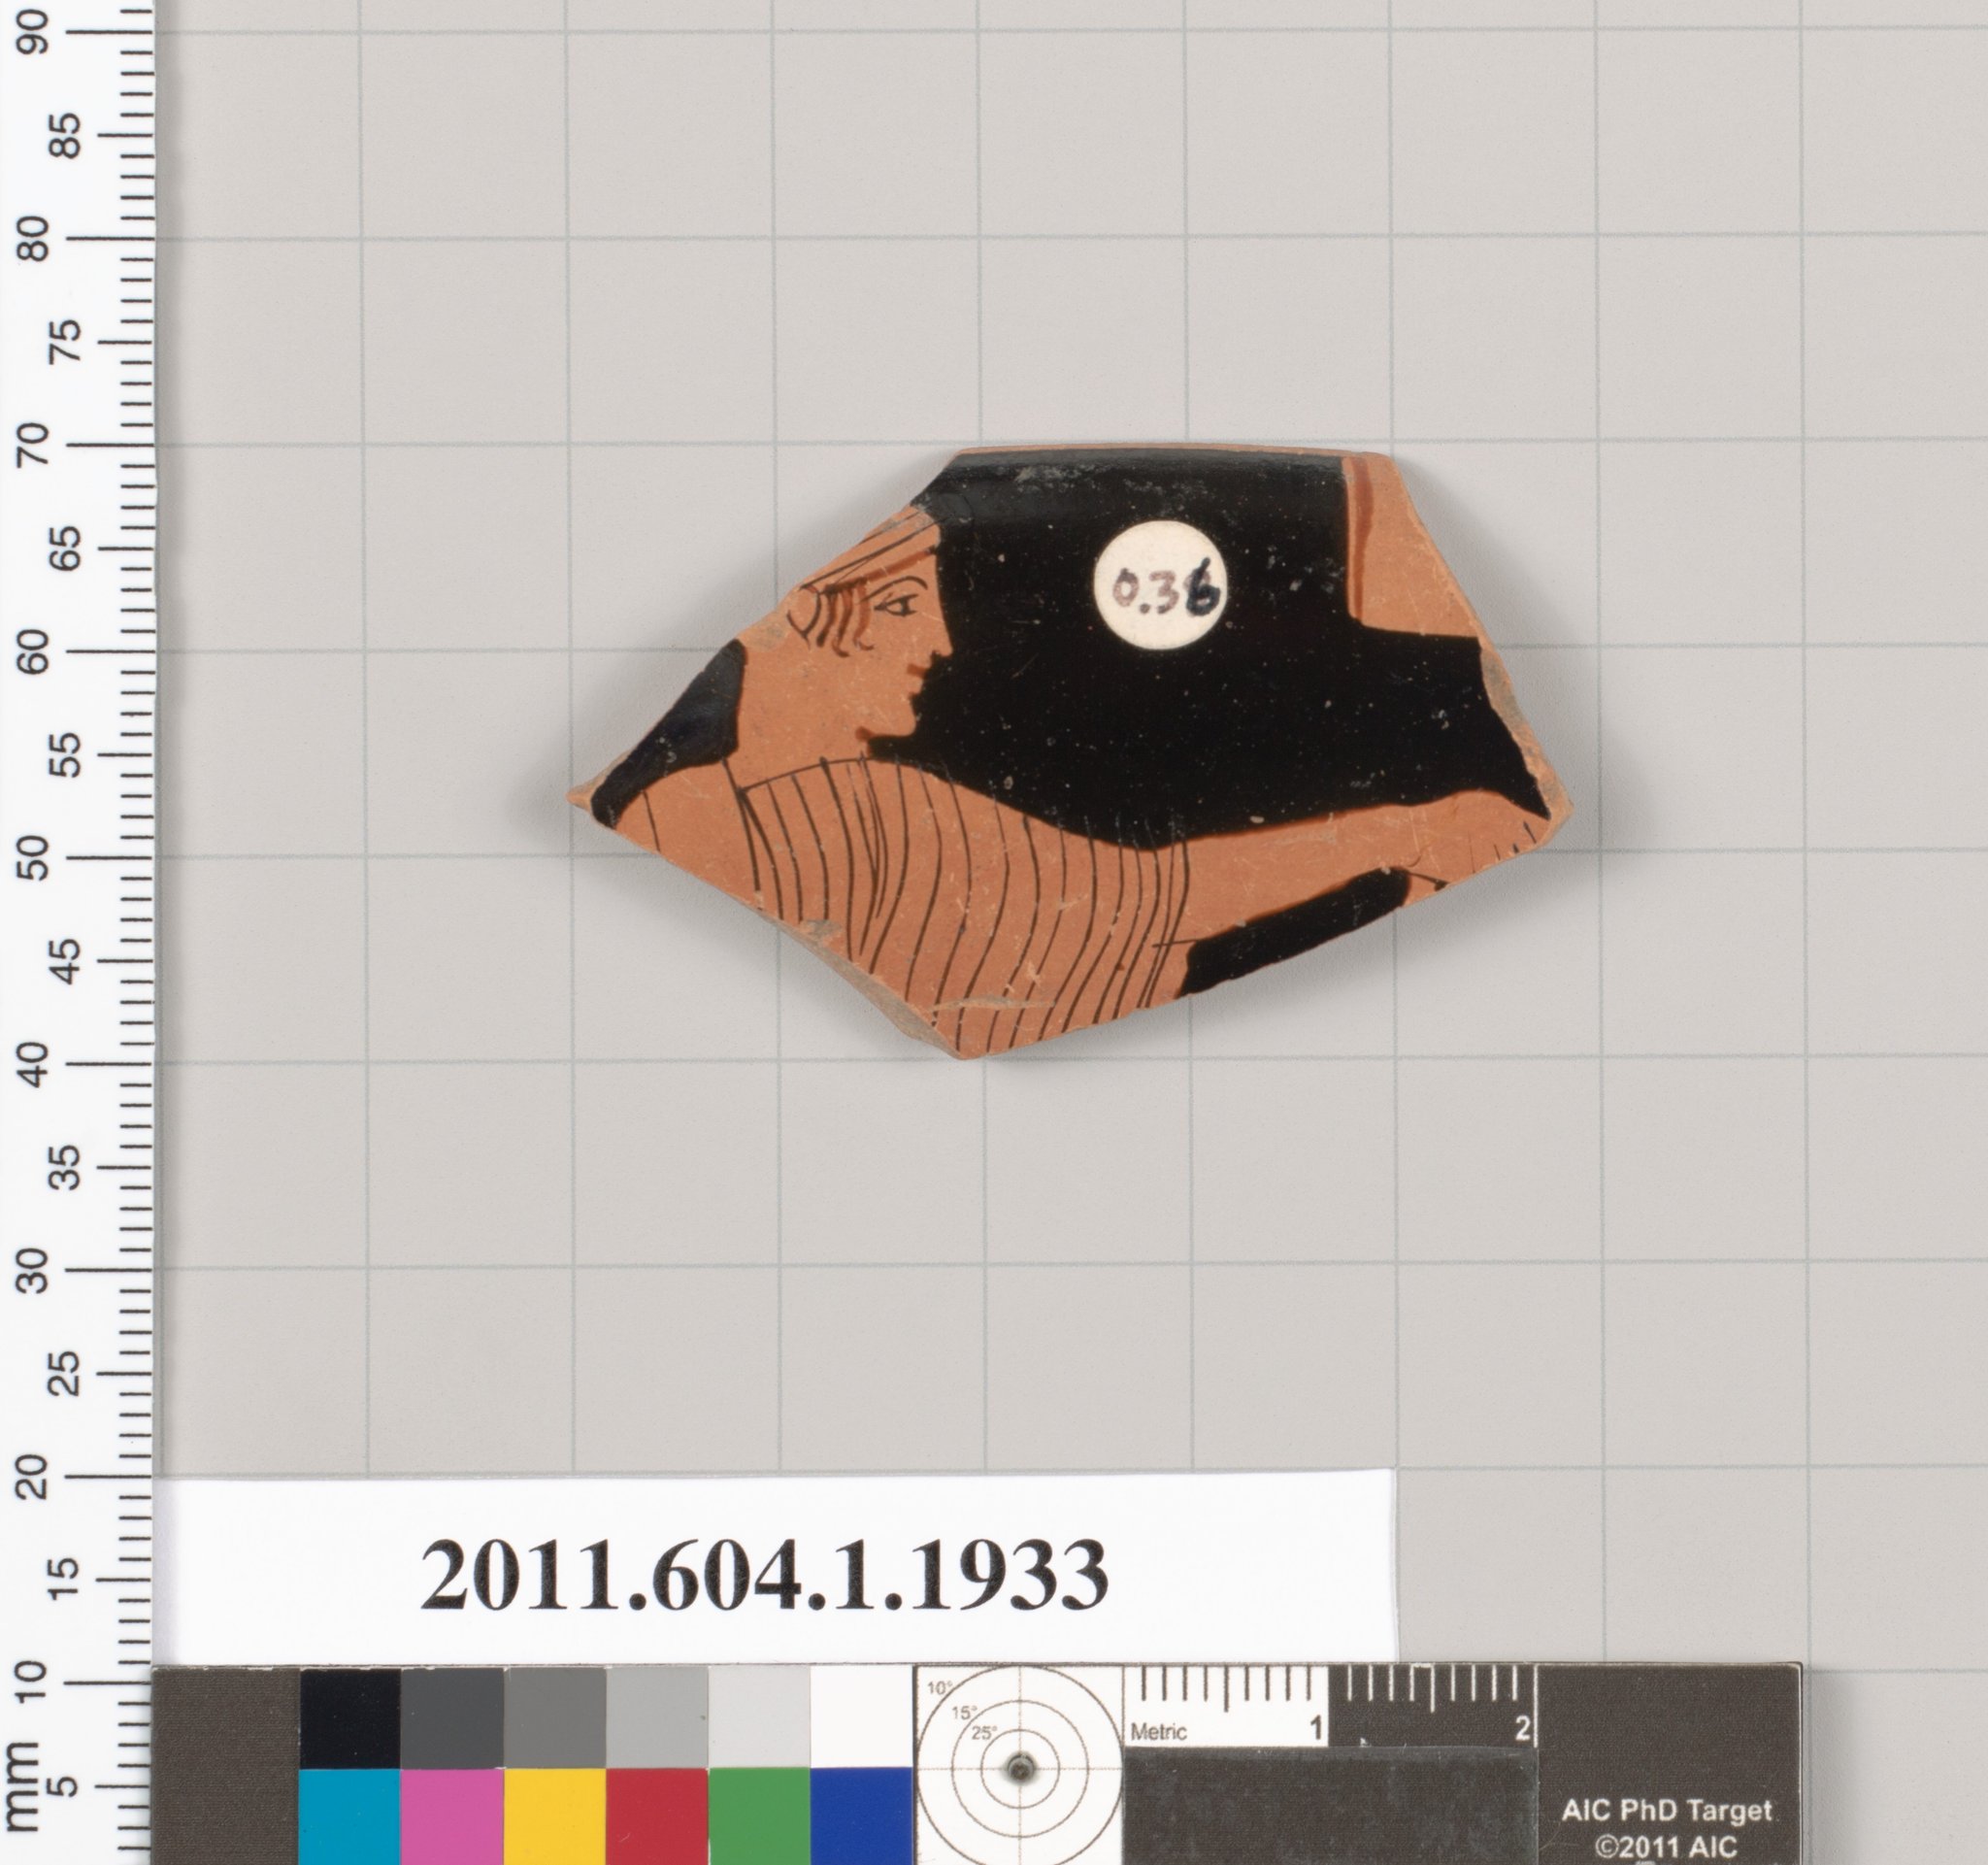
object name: kylix fragment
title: Terracotta rim fragment of a kylix (drinking cup)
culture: greek, attic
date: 460-450 BCE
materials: terracotta